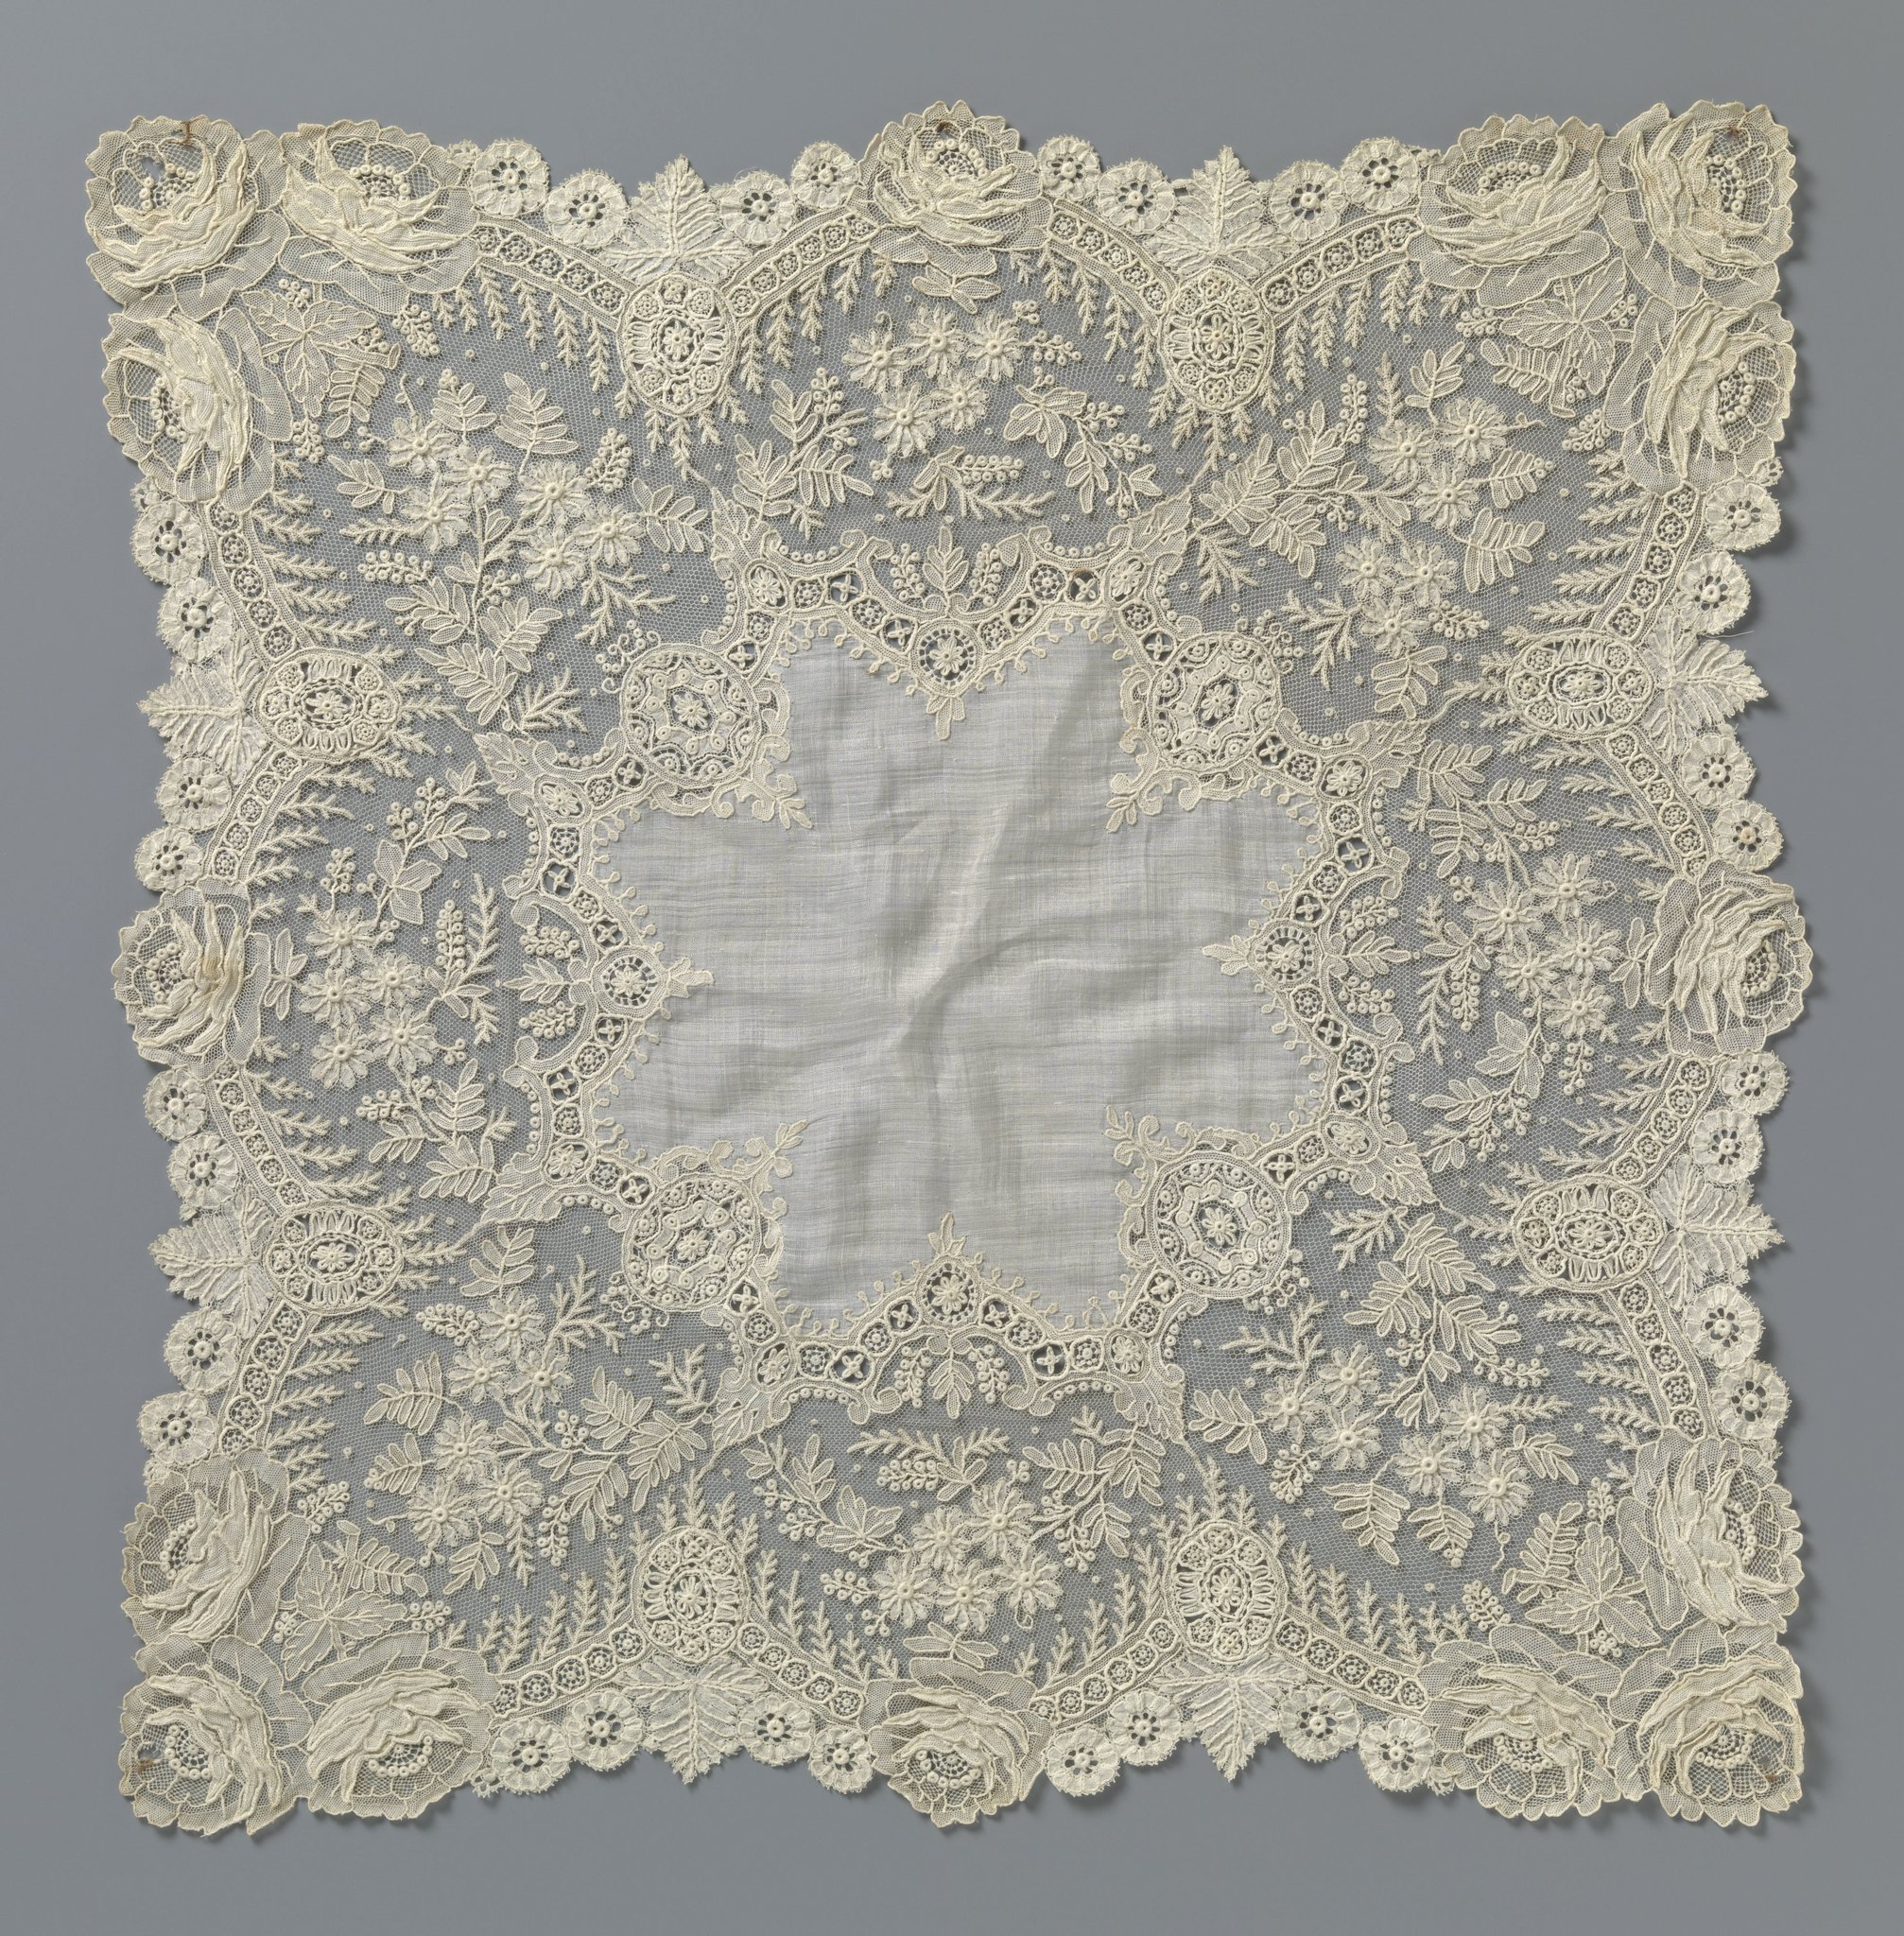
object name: handkerchief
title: Zakdoek met een rand van naaldkant met dubbele vierpas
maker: Anonymous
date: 1860-1870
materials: linen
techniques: lace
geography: brussels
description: Zakdoek met een rand van naturelkleurige naaldkant, Brusselse gaaskant. Een achtlobbig batisten middenstuk is door een kanten dubbele vierpas omgeven. Hierin staan naar rechts roterende takjes van 'vergeetmijnietjes' (kloskant). Een binnenlijst van cirkeltjes, viermaal oversneden door een ovaaltje, is begrensd door C-voluten. Van eenzelfde buitenlijst hangen fijne goudenregenblaadjes neer. In de hoeken staan telkens drie grote rozen met opgelegd reliëf. De rand bestaat uit rozetjes en wingerdblaadjes.